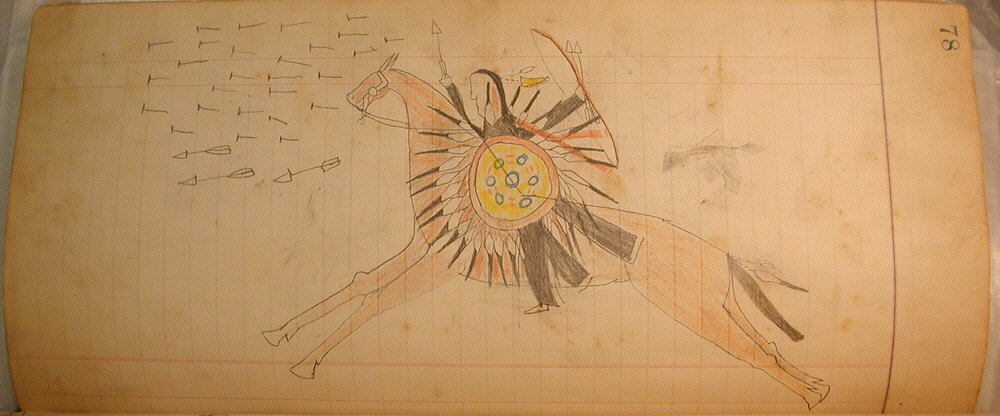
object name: drawing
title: Maffet Ledger: Drawing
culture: cheyenne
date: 1874-1881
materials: crayon, graphite, paper, watercolor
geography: united states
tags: bow and arrow,men,horses